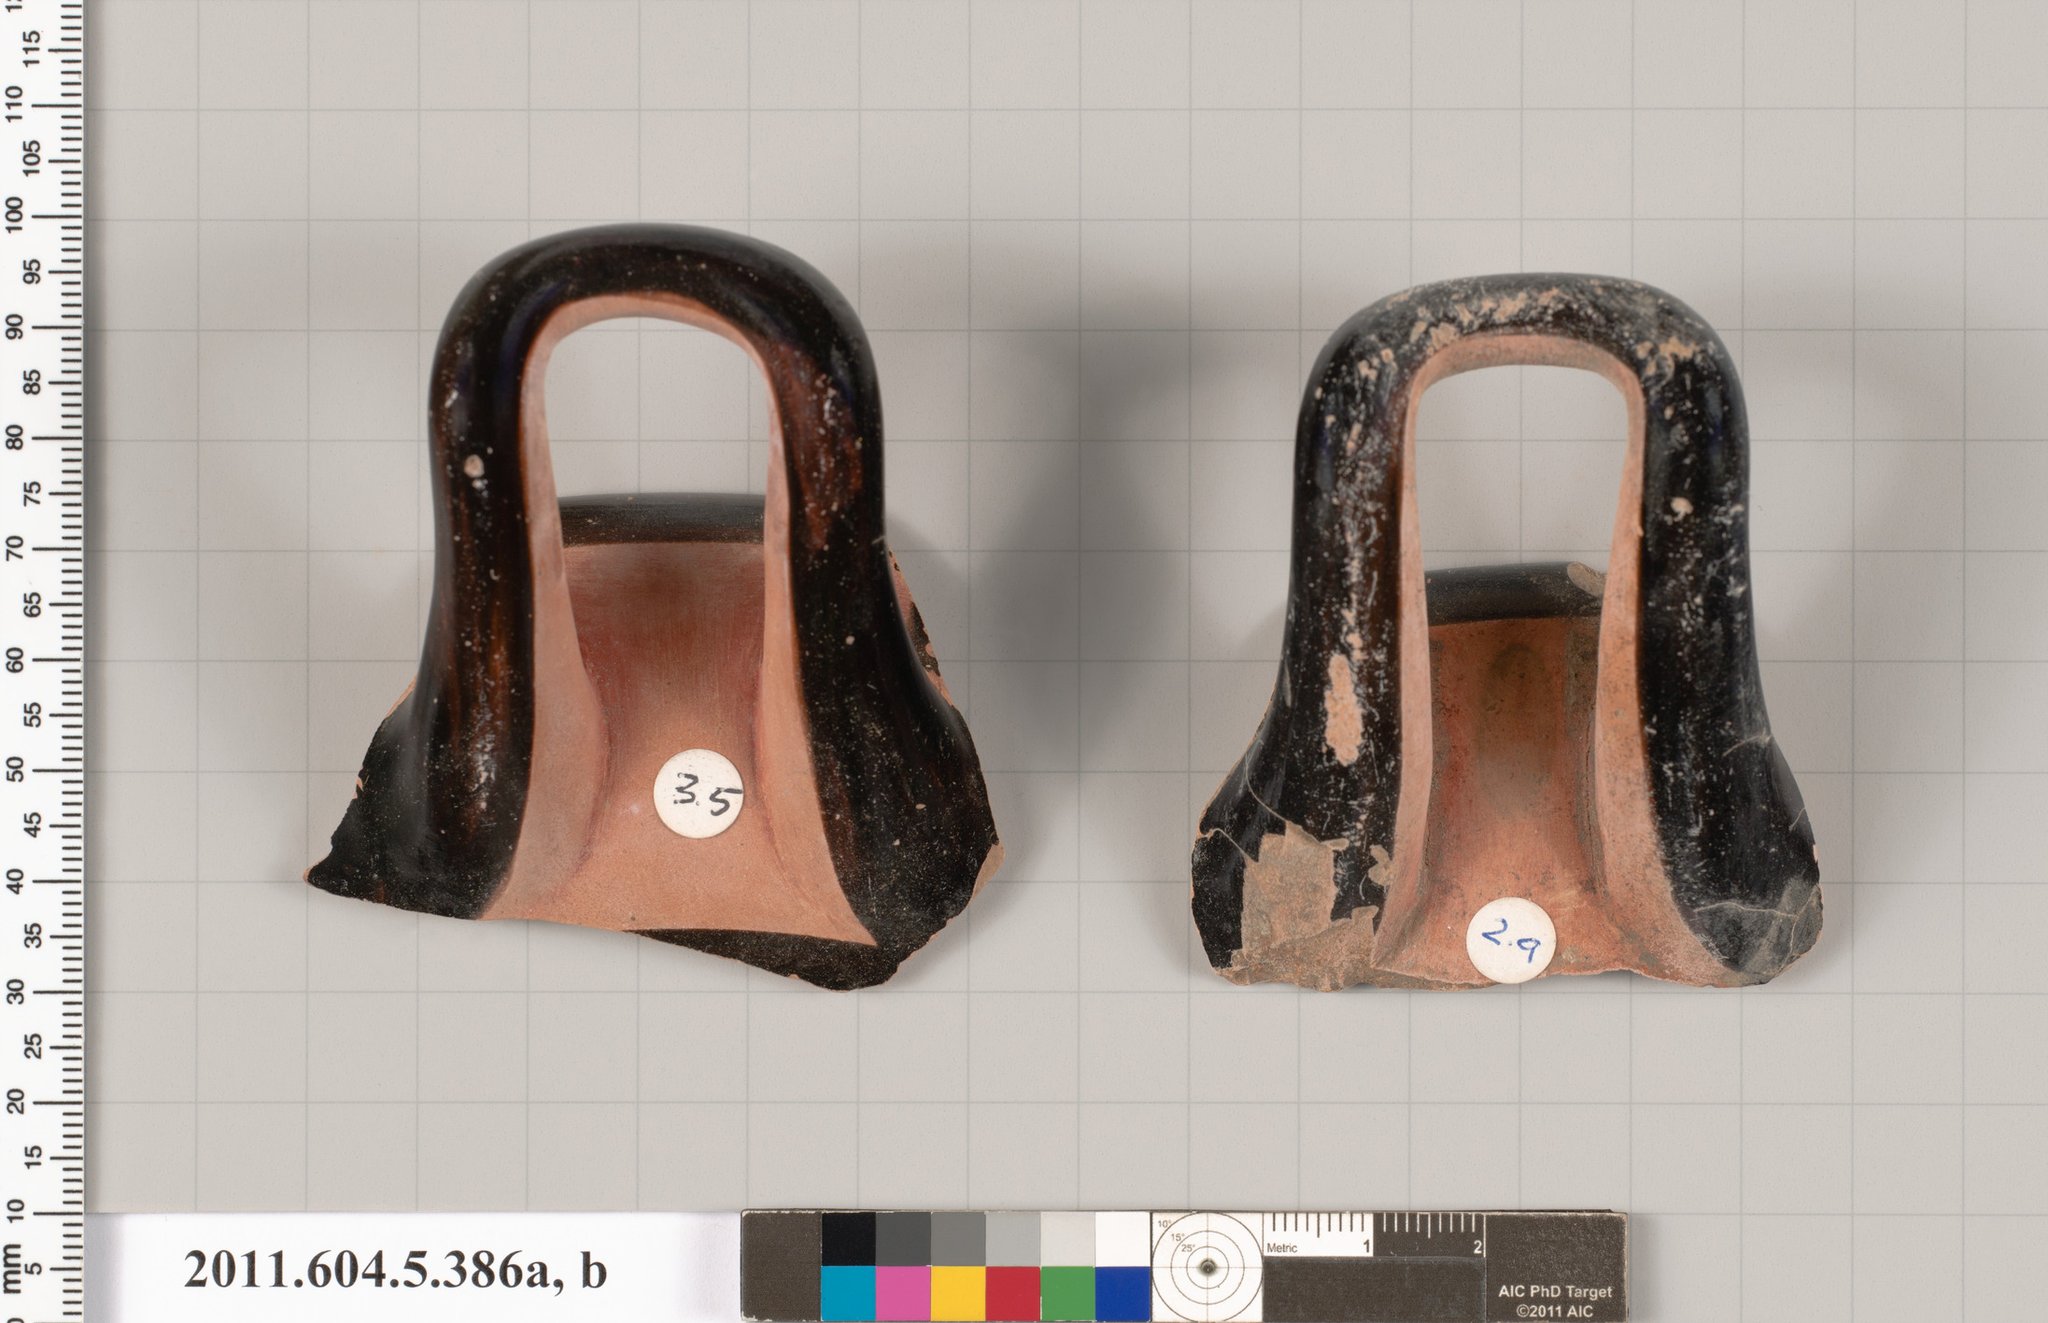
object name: kylix fragment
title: Terracotta fragments of kylikes (drinking cups)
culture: greek, attic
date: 600-401 BCE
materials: terracotta